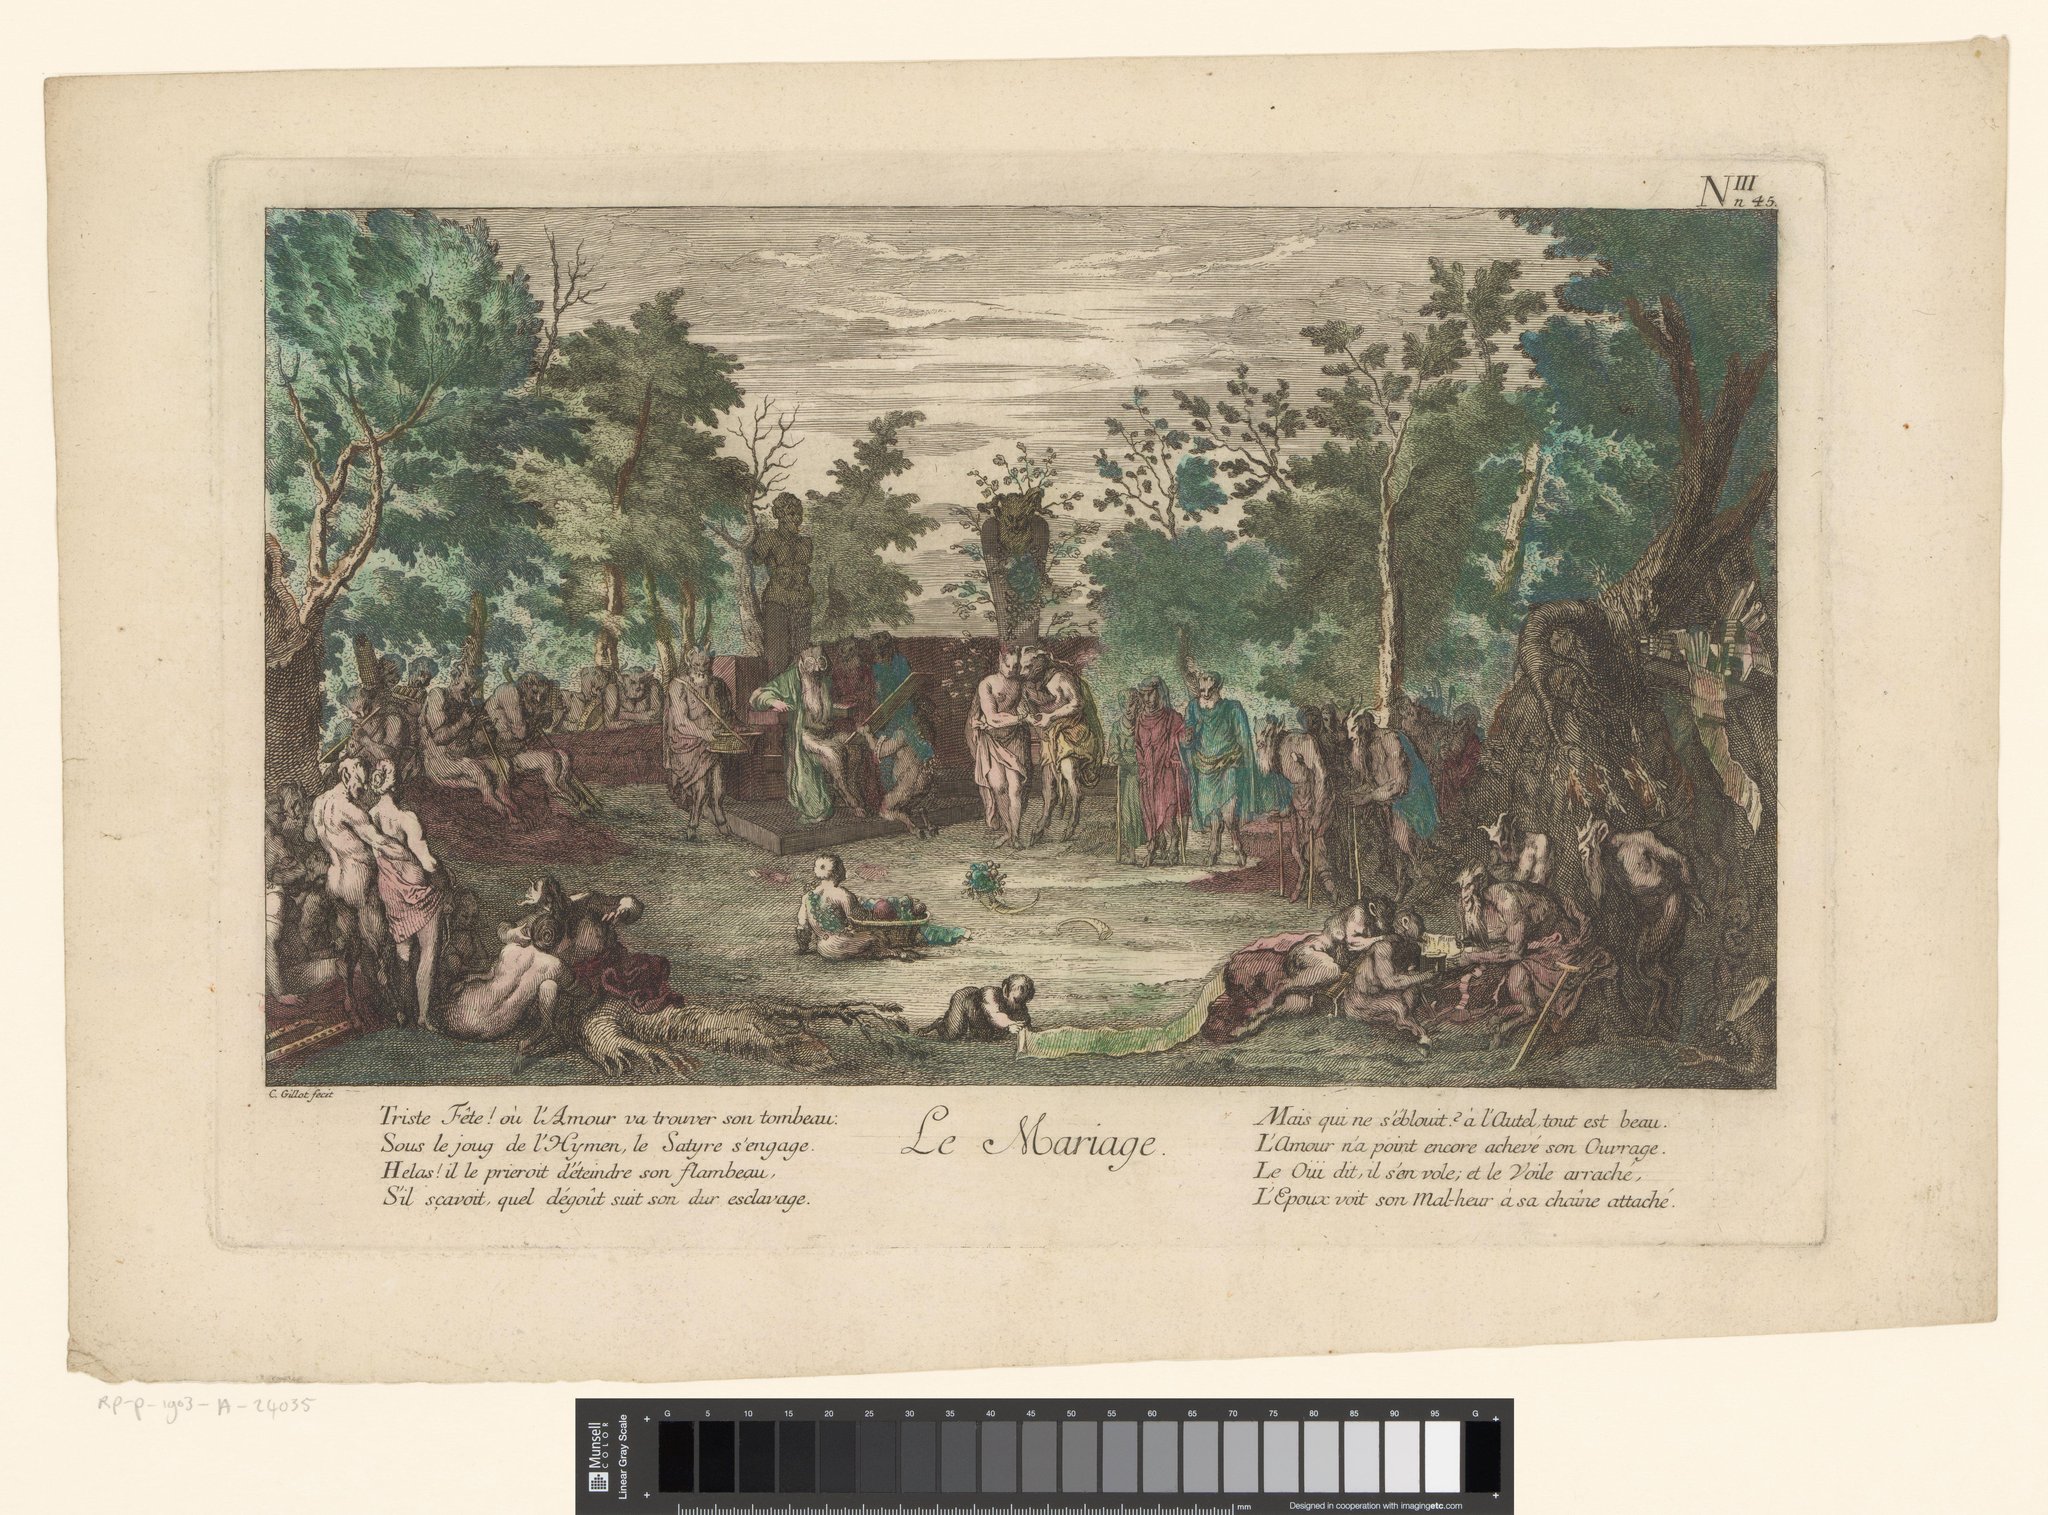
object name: print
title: Le mariage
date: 1705-1771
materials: paper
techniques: etching, hand coloring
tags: satyr(s) (in general), (civil) marriage ceremonies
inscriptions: collector's mark: Lugt 2228